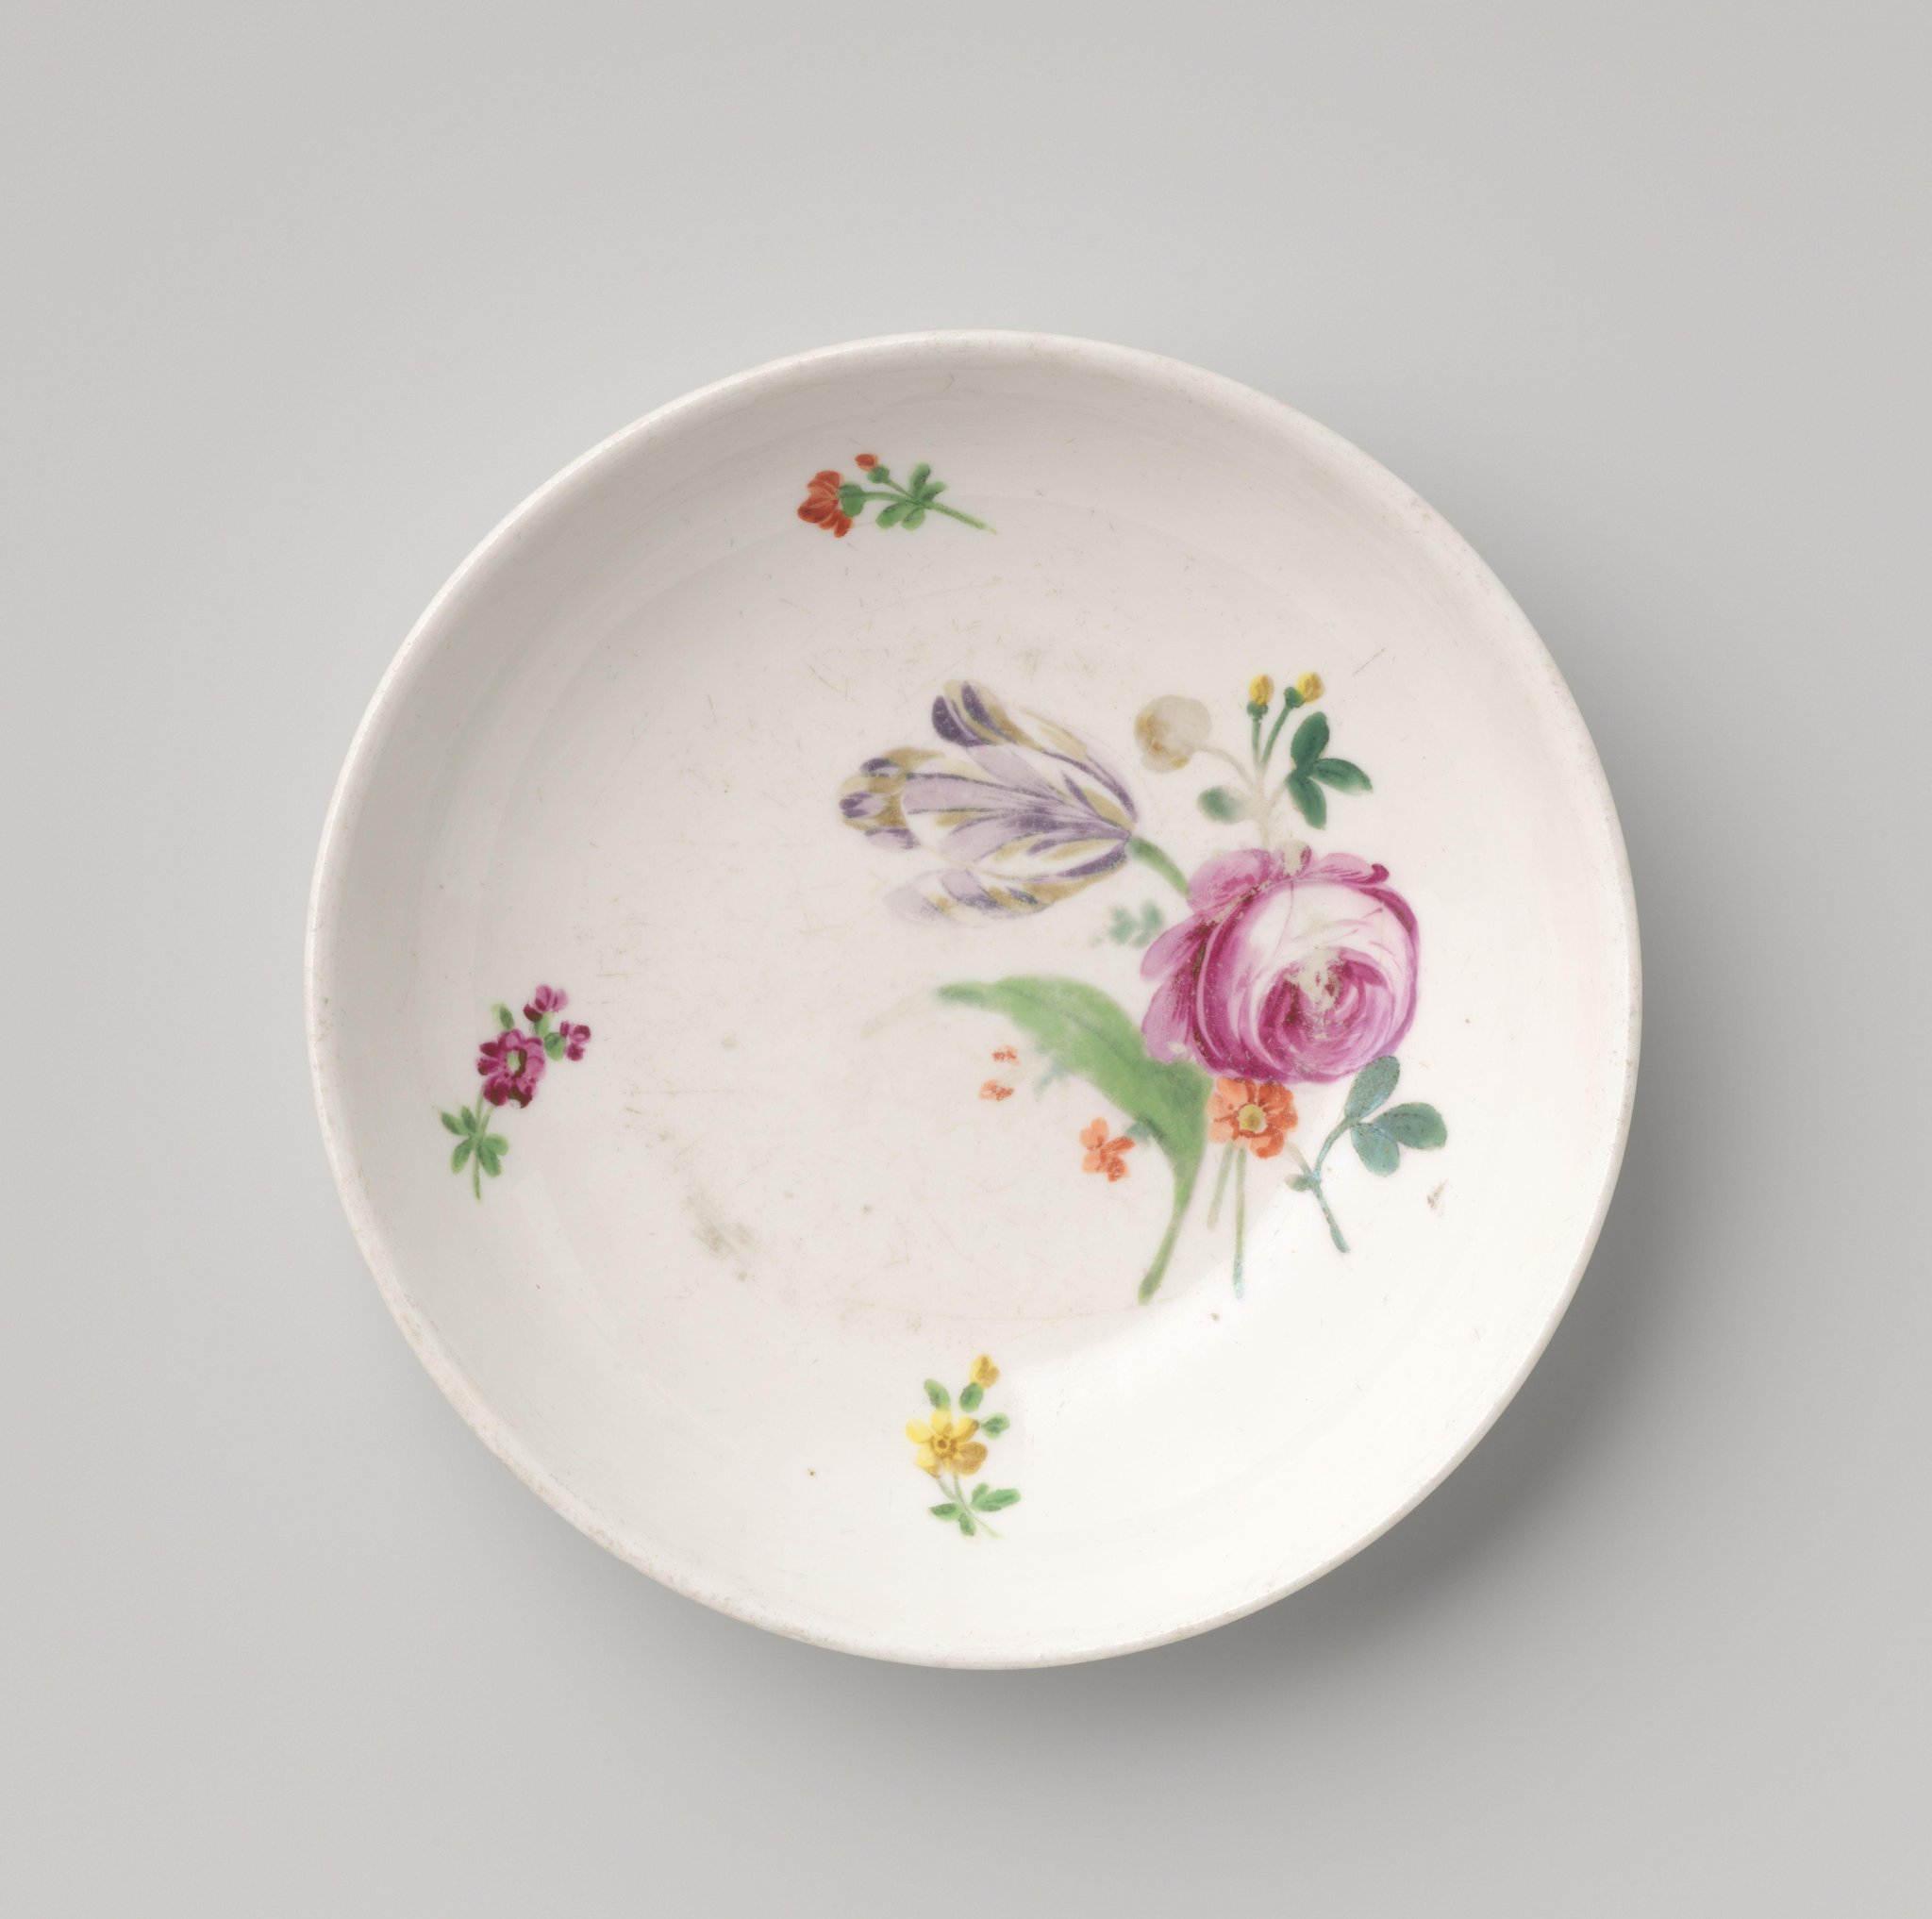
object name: service set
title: Saucer with a bouquet and flower sprays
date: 1800-1849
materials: glaze, paint, porcelain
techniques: firing, forming, turning, vitrification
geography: vienna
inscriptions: mark: ‘schild/ A/ 38/ 21/ 87’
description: Schotel, onderdeel van een servies beschilderd met veelkleurige bloemboeketten en strooibloemen. Merken (niet voor alle schotels, bk-1956-63-34/40, gelijk): o.a. in paars het getal 14; ingegrift de getallen 42 en/of 808,818. In onderglazuur blauw een wapenschild met twee dwarsbalken.